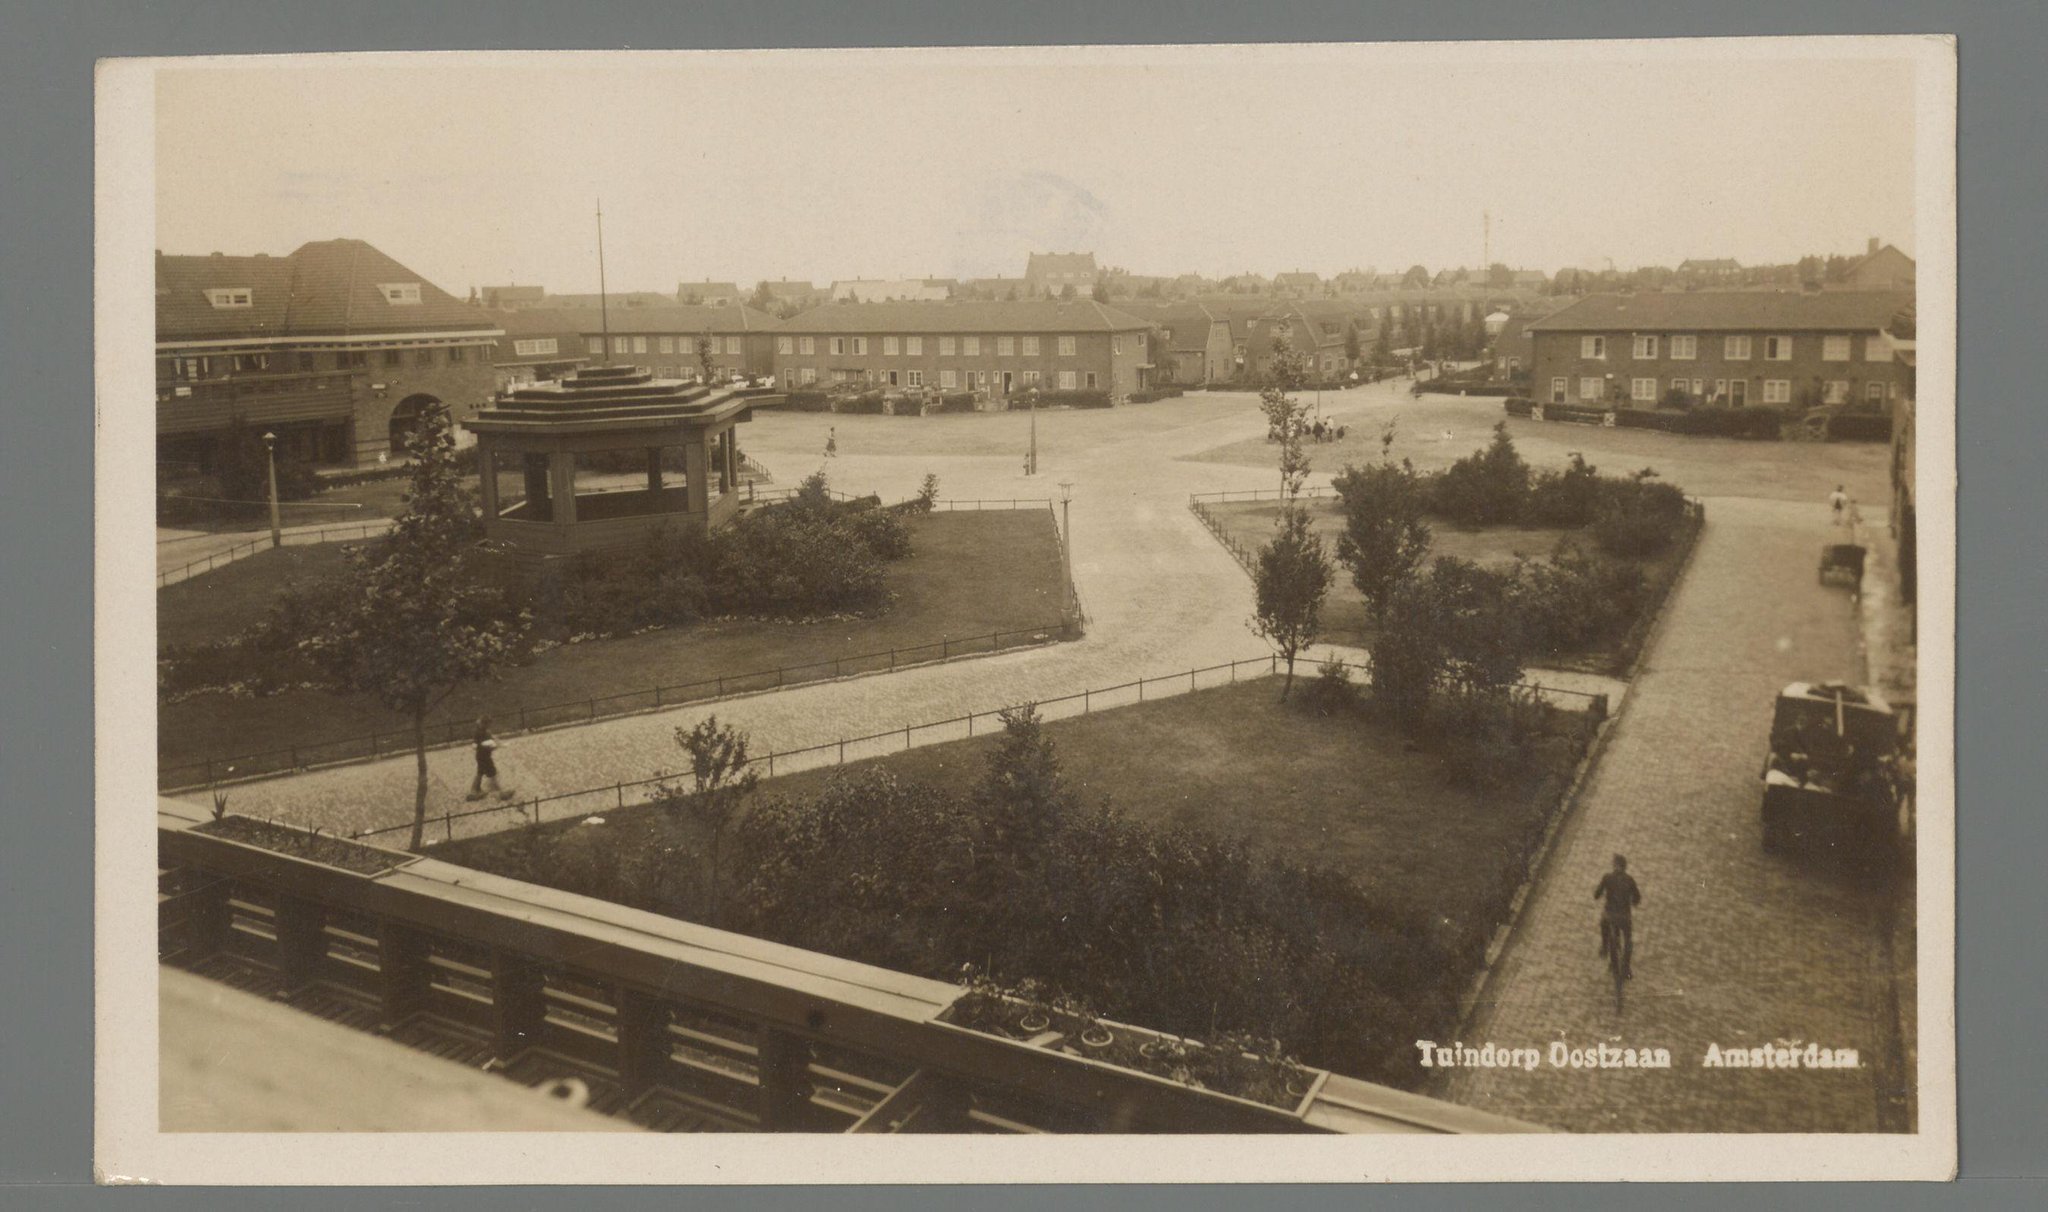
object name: ansichtkaart, prentbriefkaart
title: Tuindorp Oostzaan Amsterdam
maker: Anonymous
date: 1919-1929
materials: photographic support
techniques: photography, writing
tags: village square, place, amsterdam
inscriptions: postage stamp